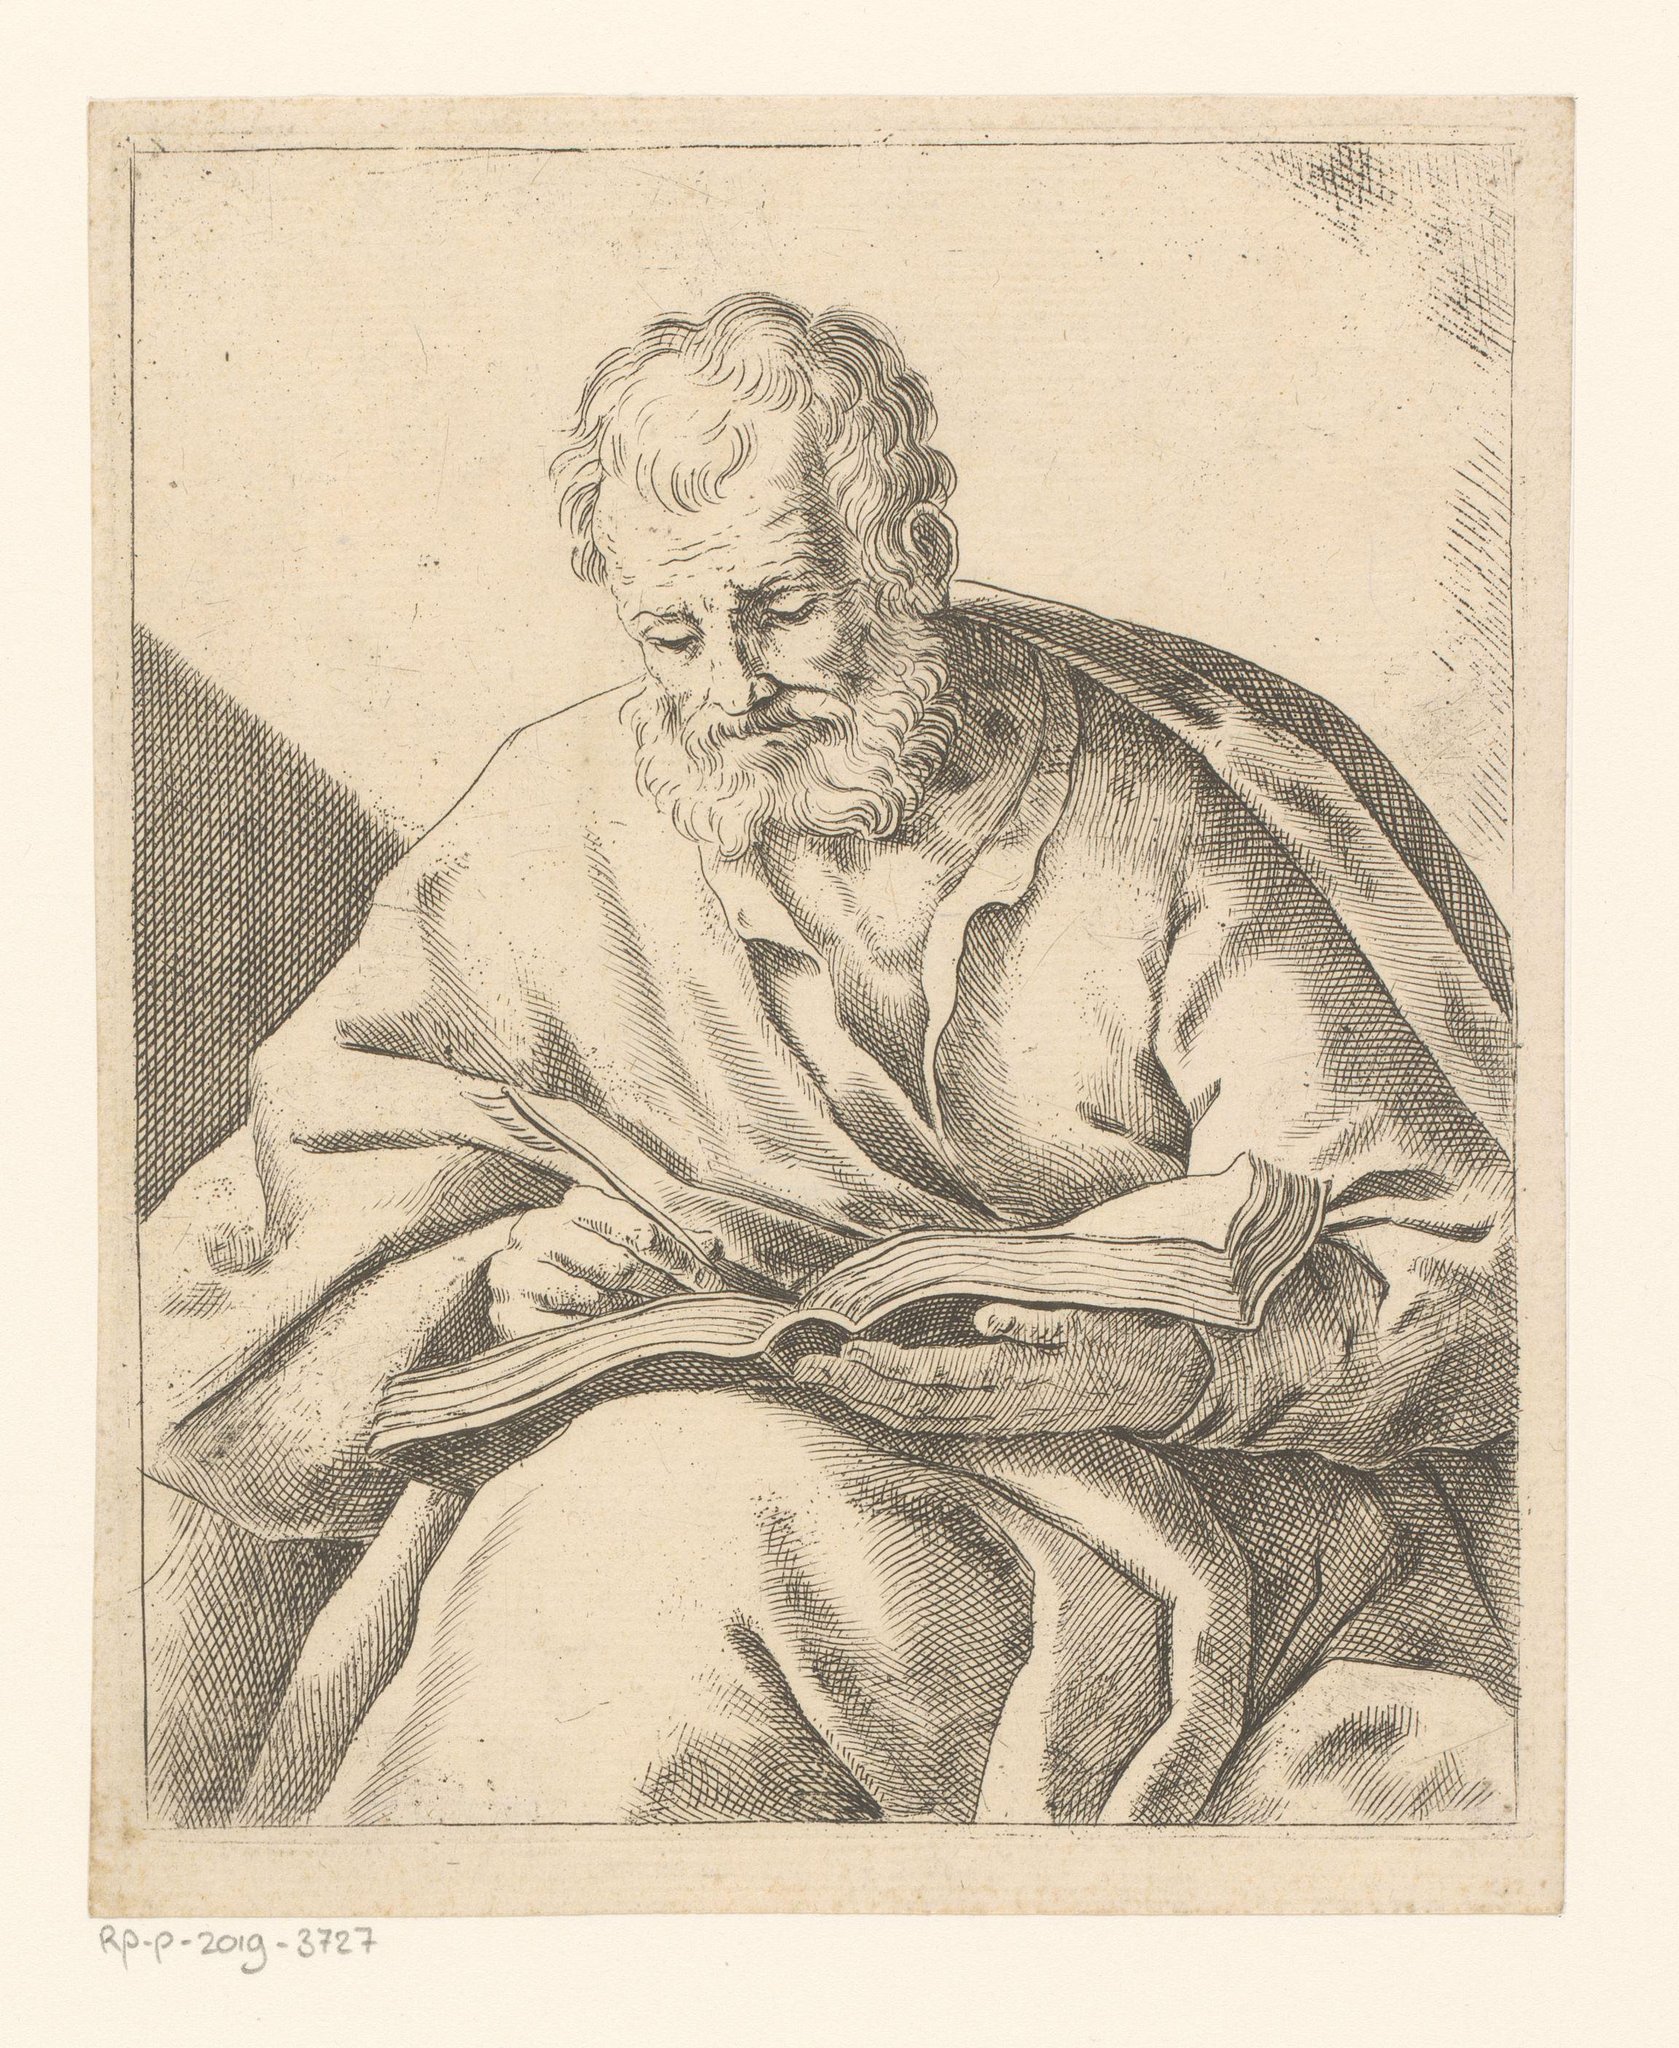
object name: print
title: Evangelist Marcus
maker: Anonymous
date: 1600-1699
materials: paper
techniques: etching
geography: italy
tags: st. mark the evangelist writing the gospel, usually a (winged) lion present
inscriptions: collector's mark: Lugt 2228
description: Monogram G[R...] op andere prent uit deze serie (RP-P-2019-3728).